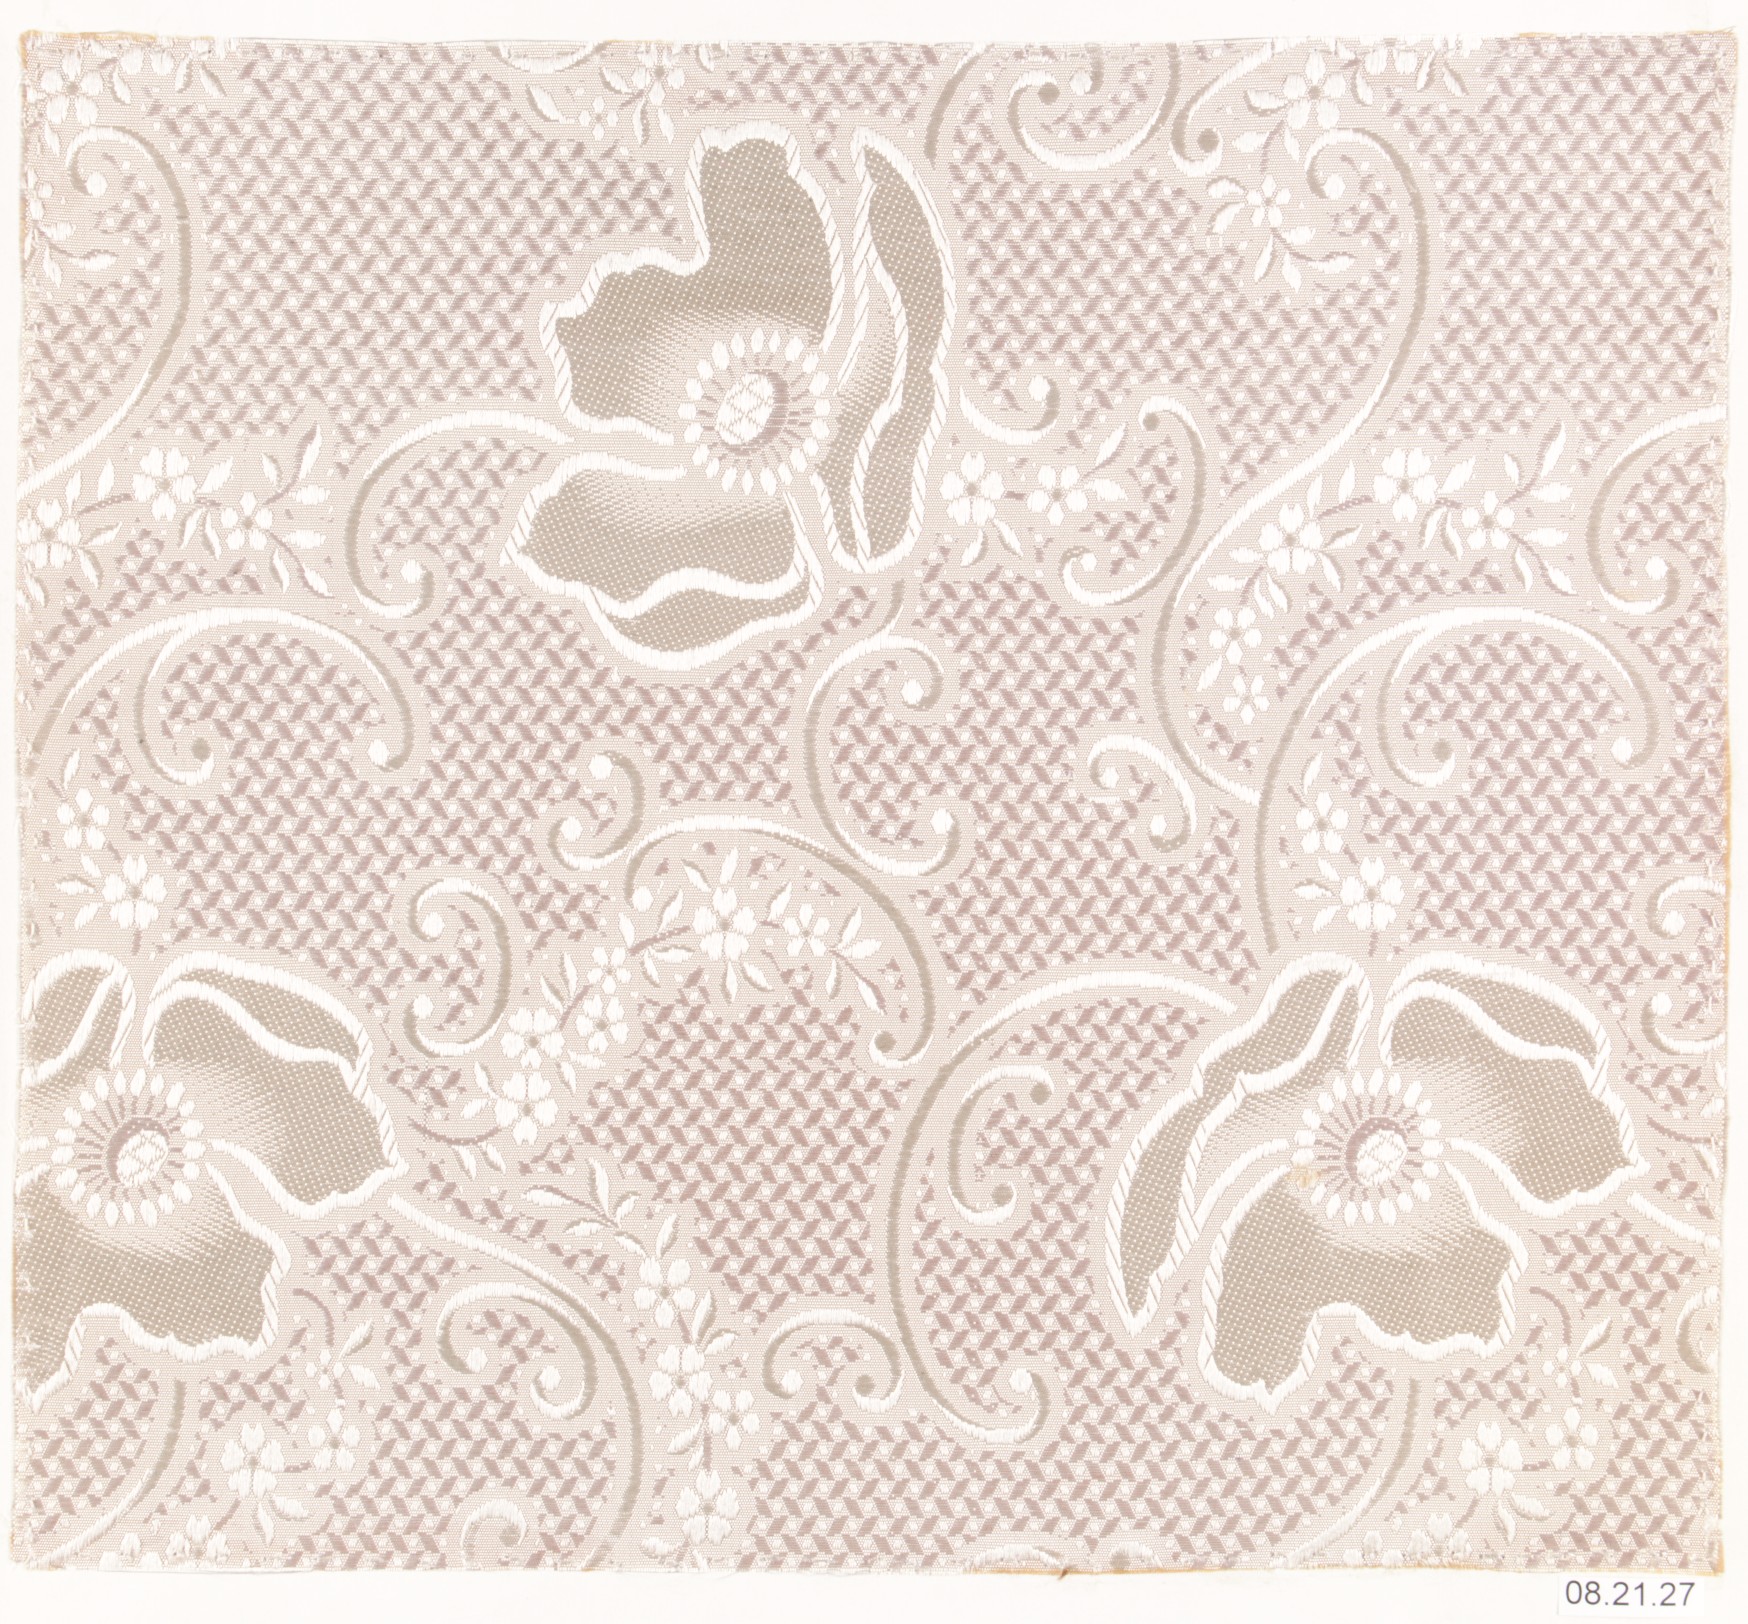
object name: textile sample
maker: Anonymous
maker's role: designer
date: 1900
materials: silk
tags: flowers